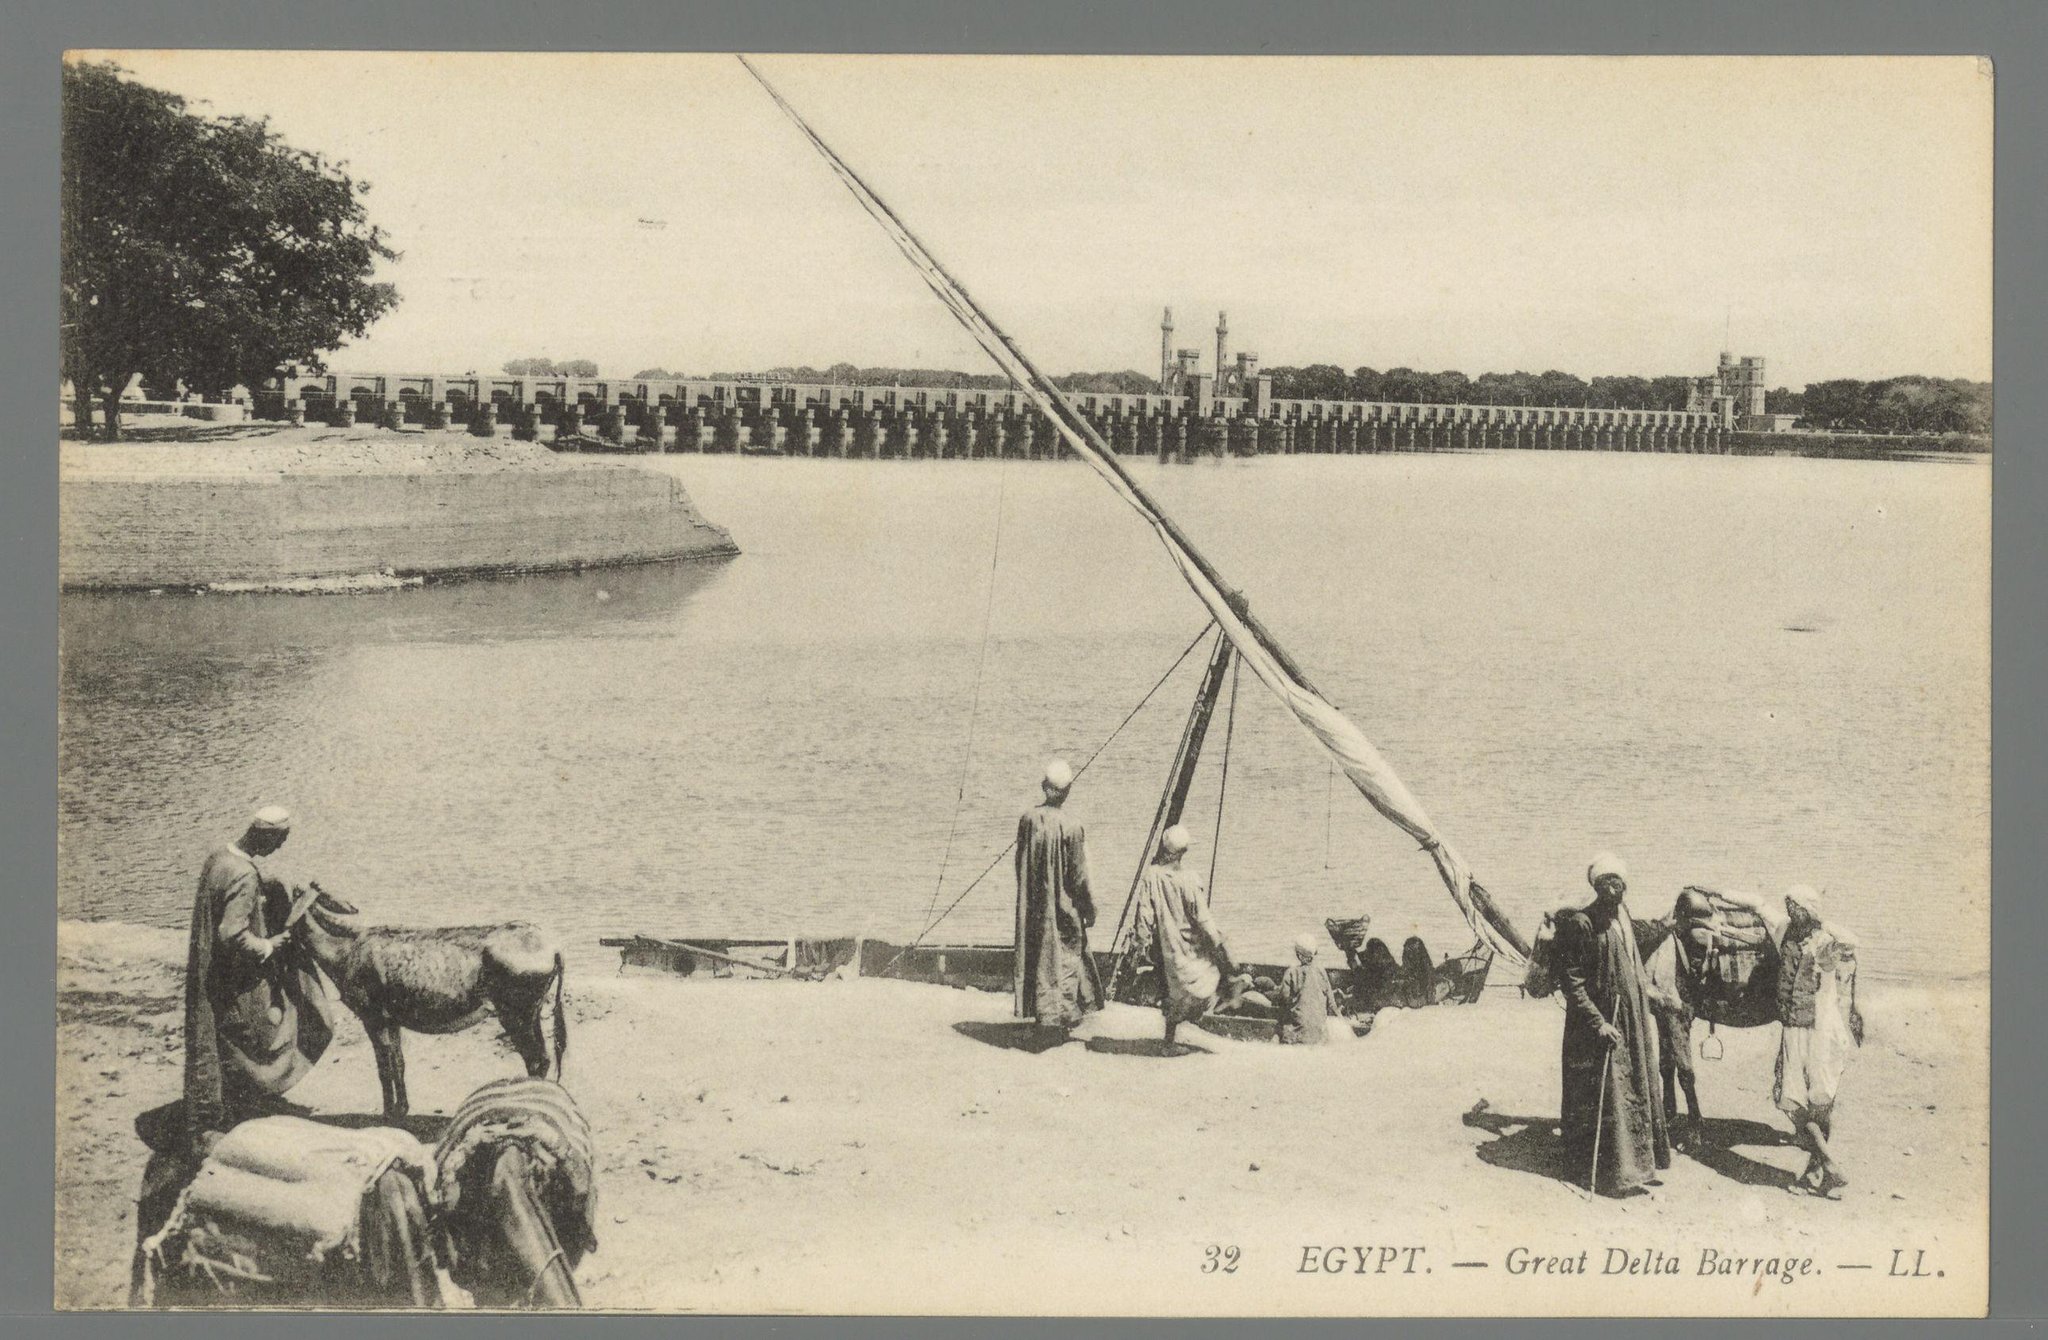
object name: ansichtkaart, prentbriefkaart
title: Egypt - Great Delta Barrage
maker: Anonymous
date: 1907-1930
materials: cardboard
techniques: photograph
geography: paris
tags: river, barrage